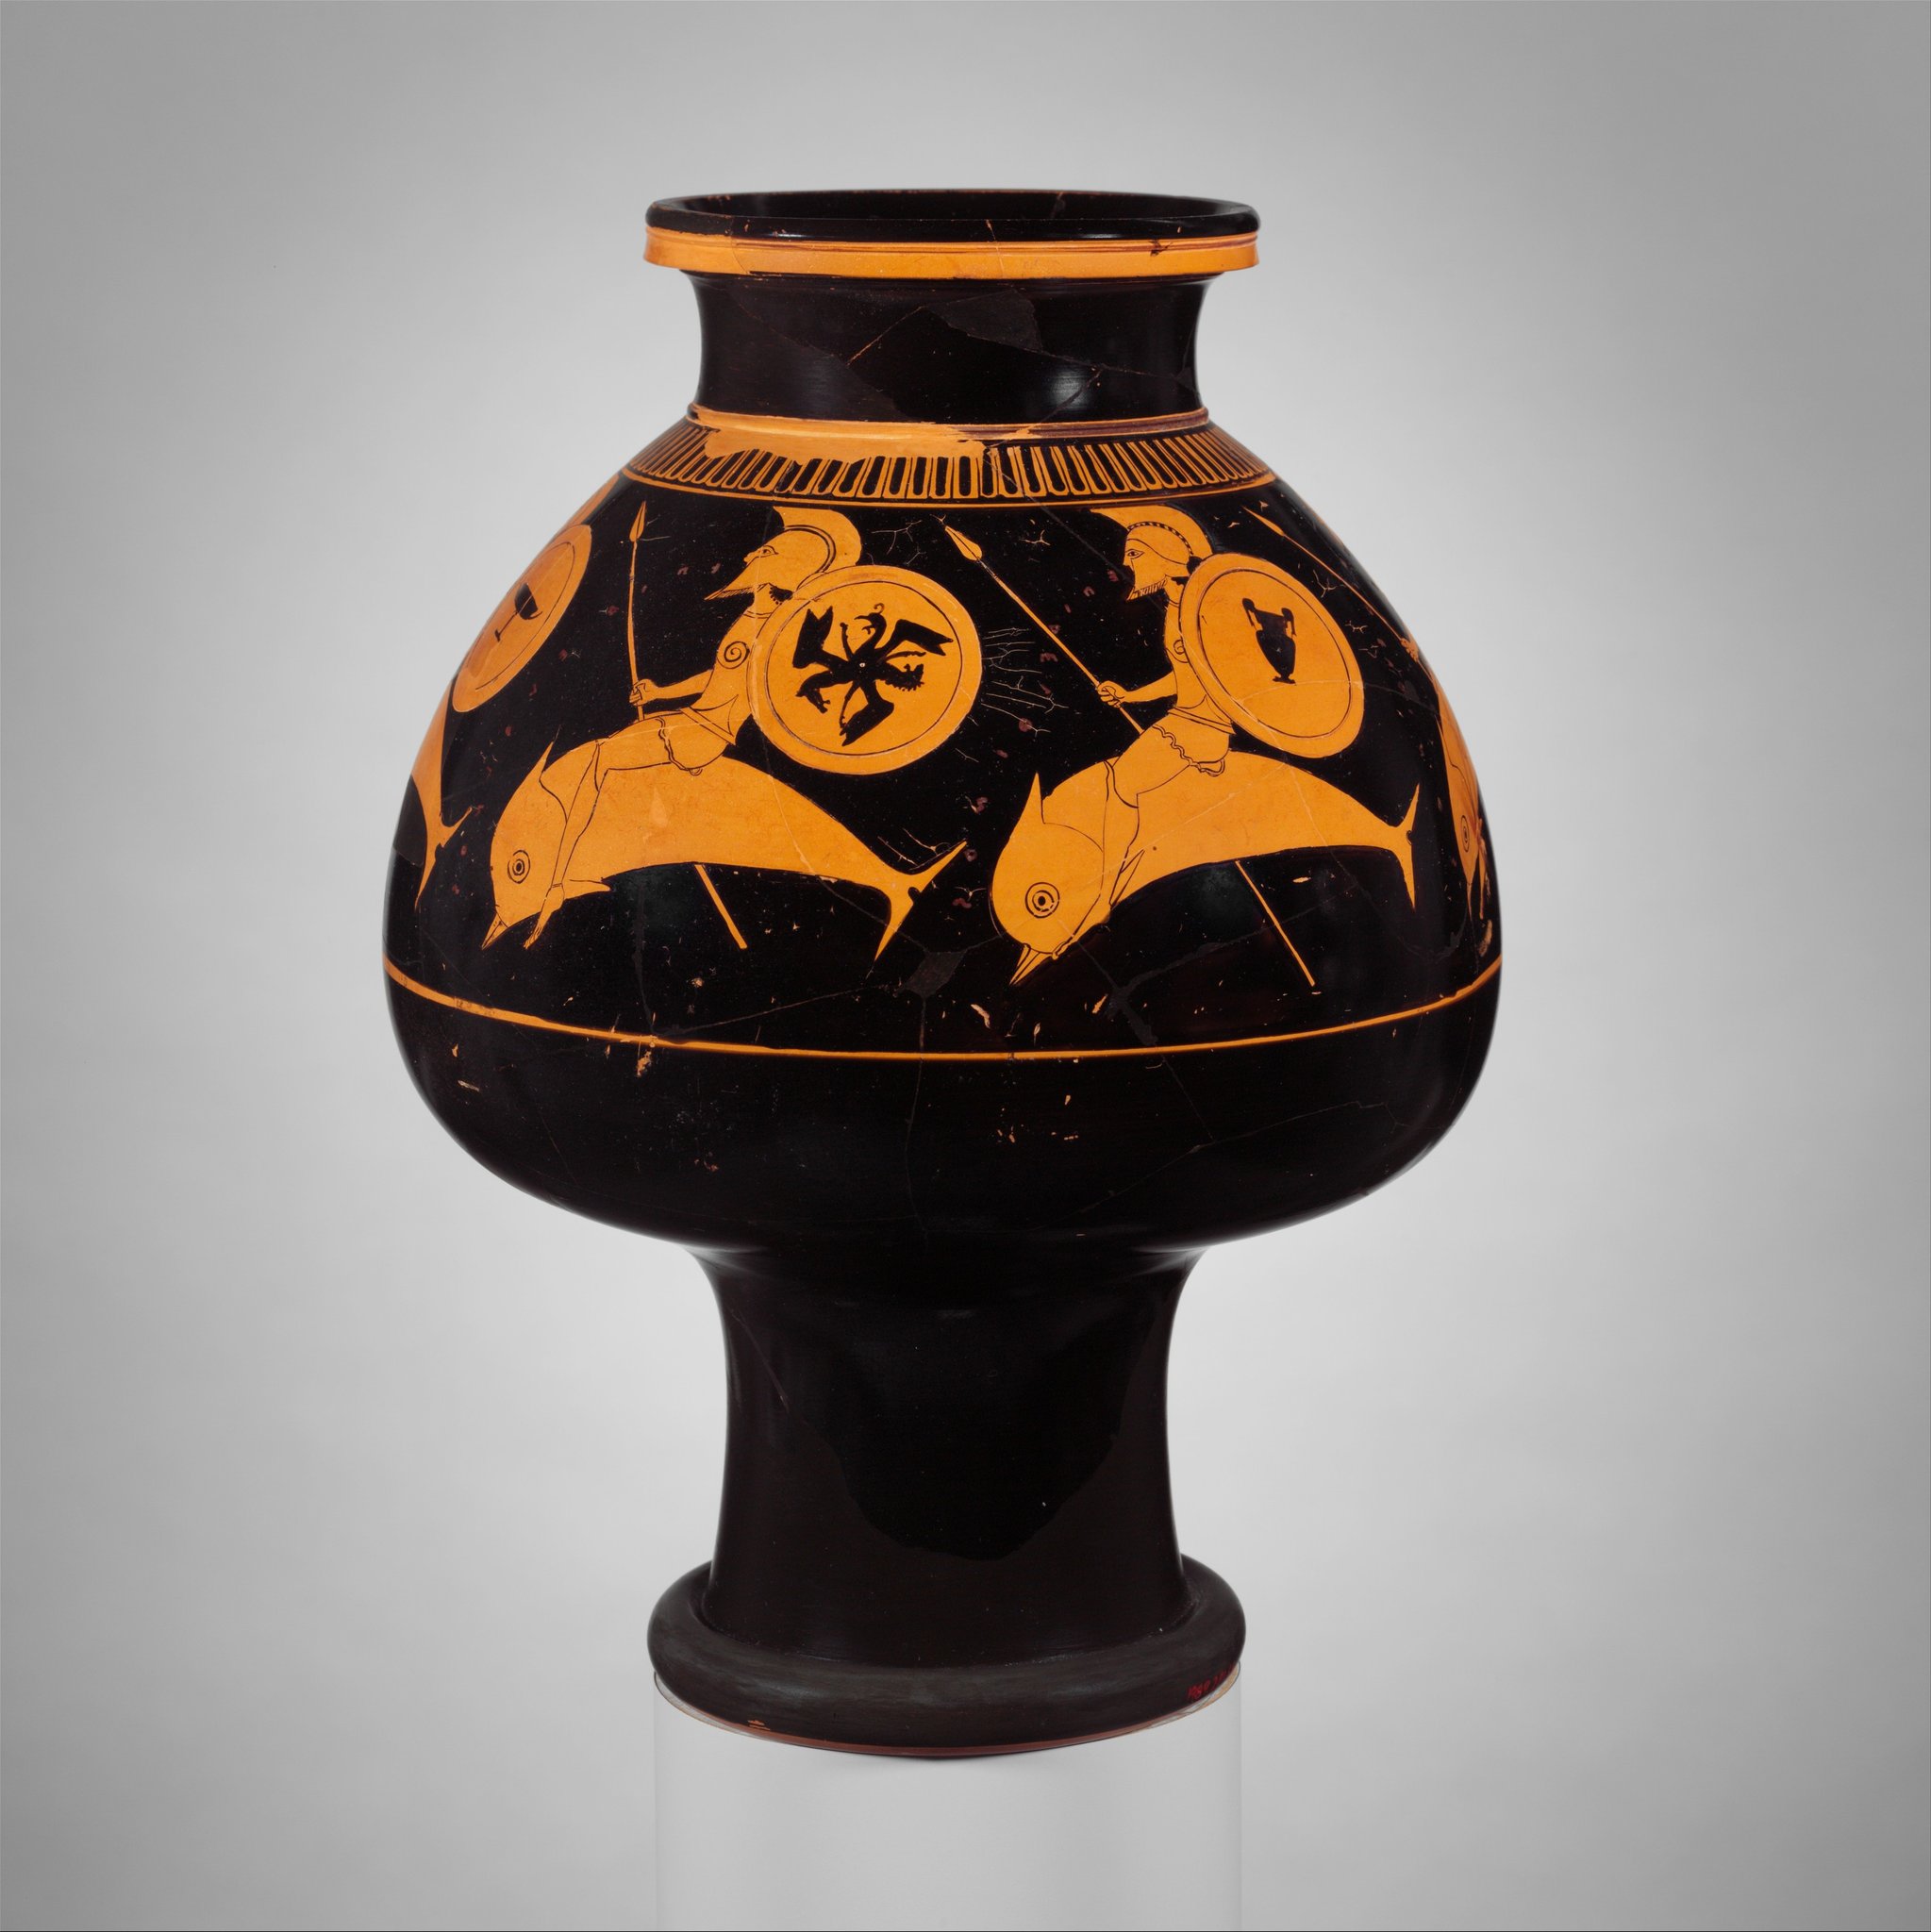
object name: psykter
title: Terracotta psykter (vase for cooling wine)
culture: greek, attic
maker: oltos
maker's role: artist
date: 520-510 BCE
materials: terracotta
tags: soldiers,shields,men,dolphins